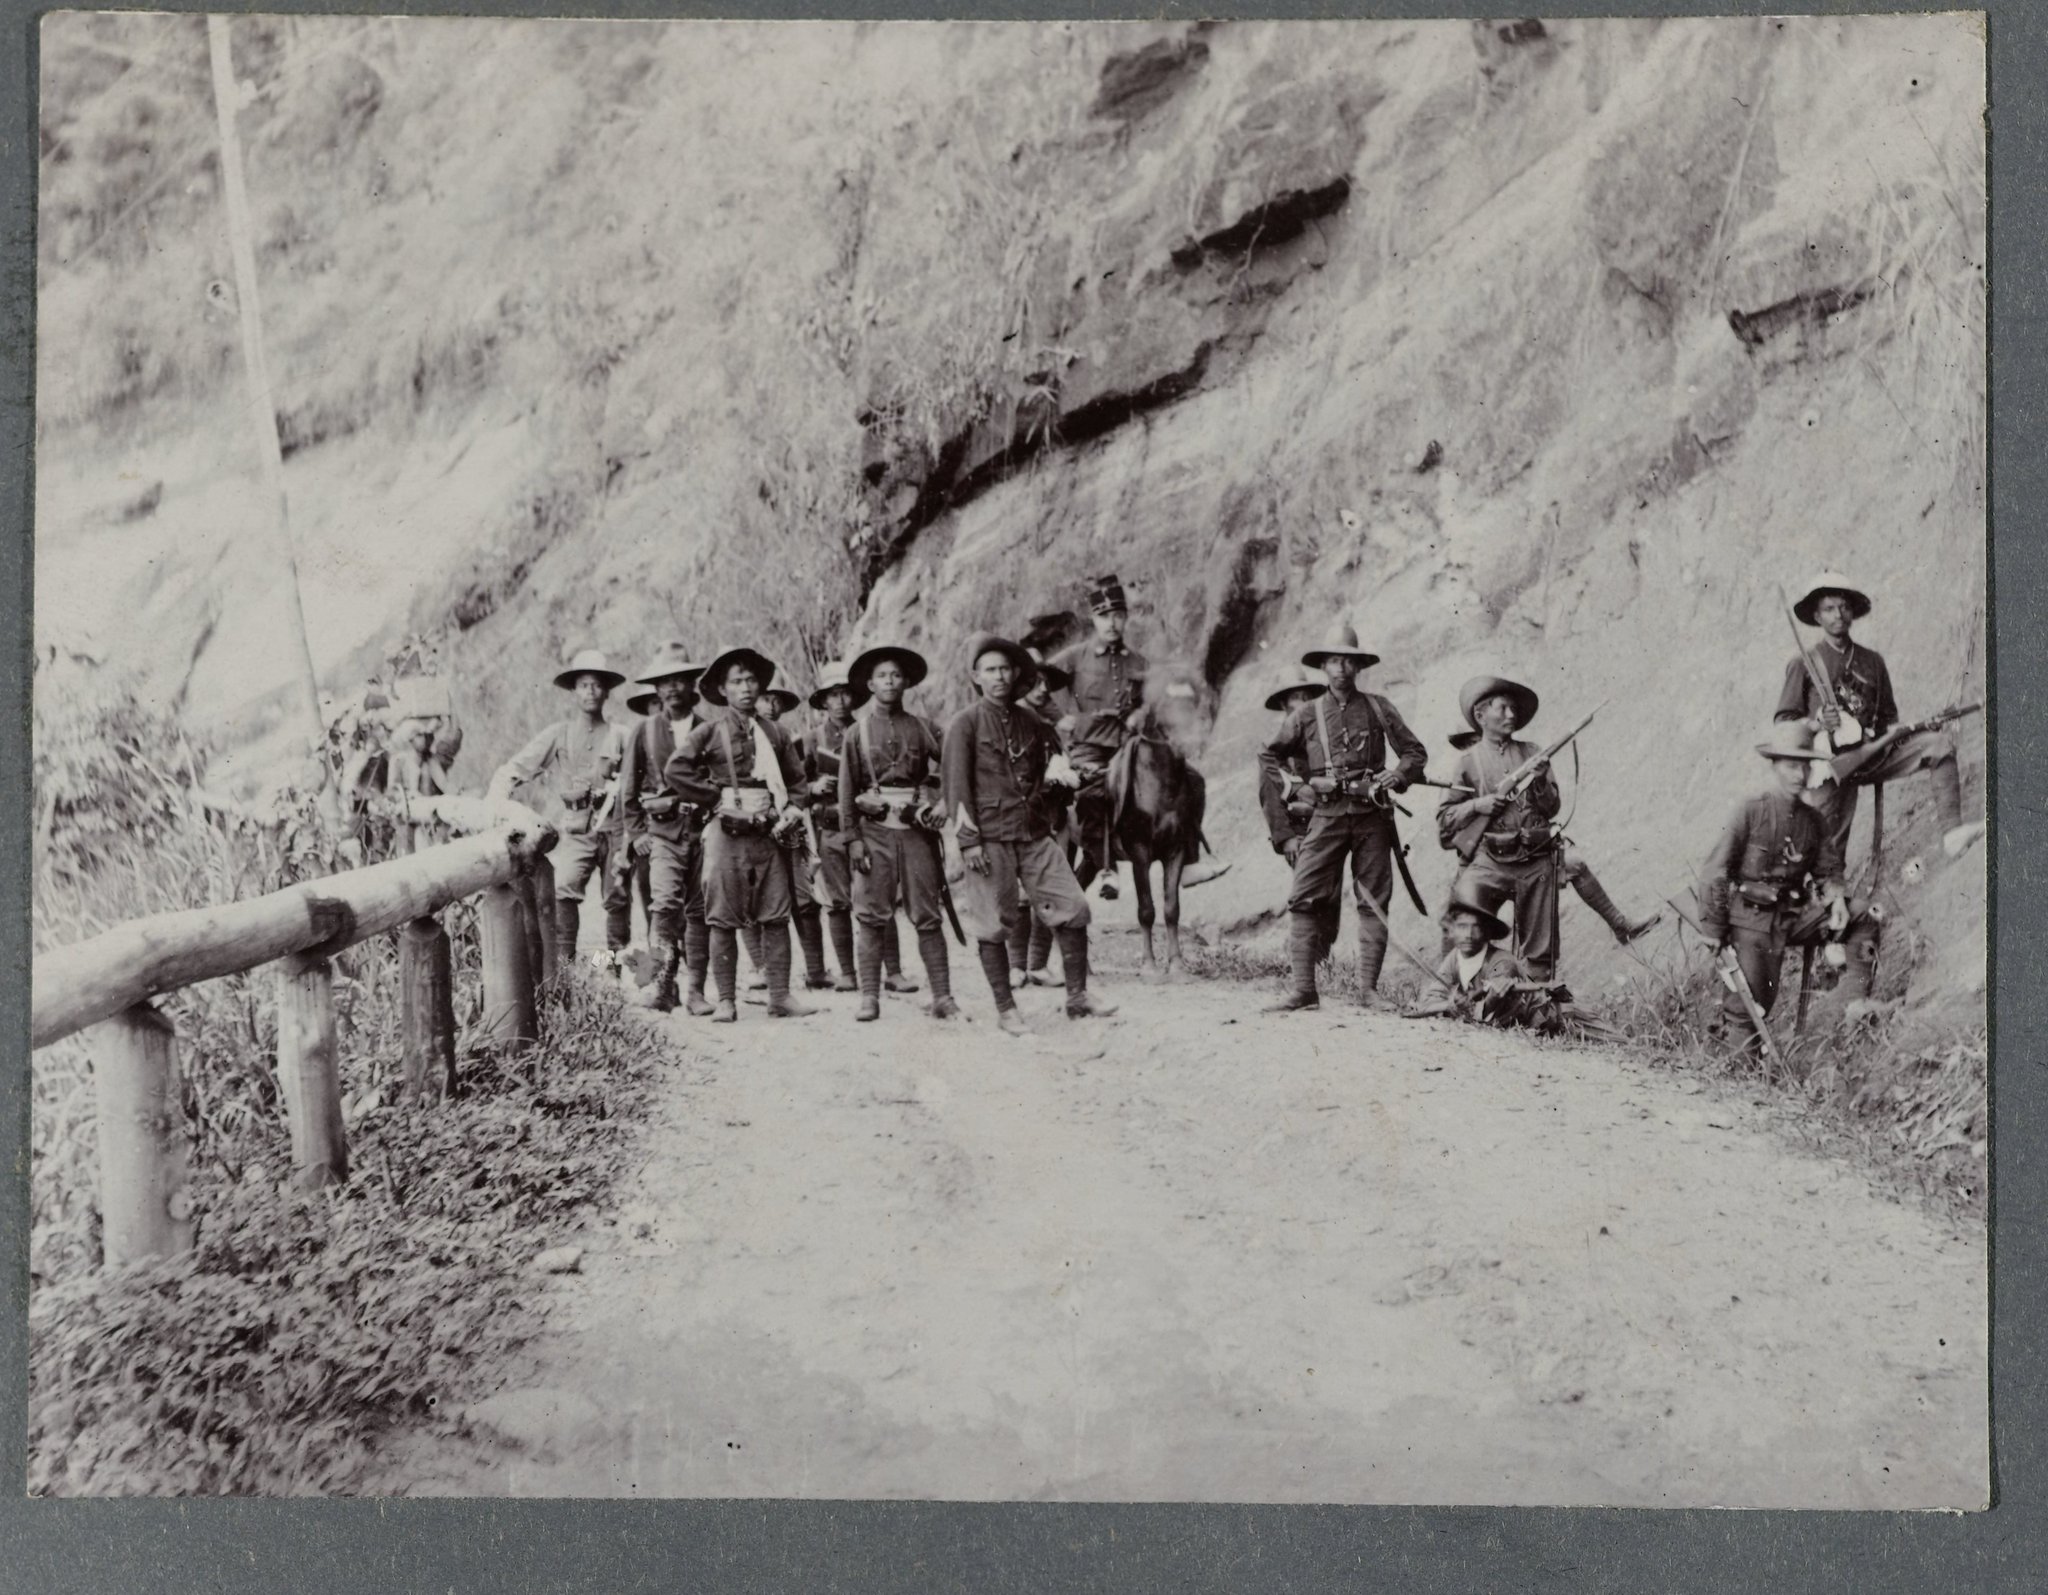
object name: photograph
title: Soldiers on the Gayo Road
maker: Anonymous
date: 1910-1913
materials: photographic support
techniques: gelatin silver print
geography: north sumatra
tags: arnhem, albertus dominicus laman trip, building activities, military service, traffic by road or path with motor-vehicle, landscapes in tropical and sub-tropical regions, road, path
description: Na de expedities naar de Gajo- en Alaslanden o.l.v. Van Daalen (eerste tocht in 1901), werd hij in 1903 belast met voorbereiding van permanente vestiging van Nederlands gezag. Aanleg van een weg van de Noordkust naar het binnenland was hierbij van groot belang. Deze zgn. Gajoweg werd aangelegd tussen 1903 en 1914, van Bireuen aan de kust naar Takinguen aan het bergmeer Danau Lauttawar, totale lengte 104 km.